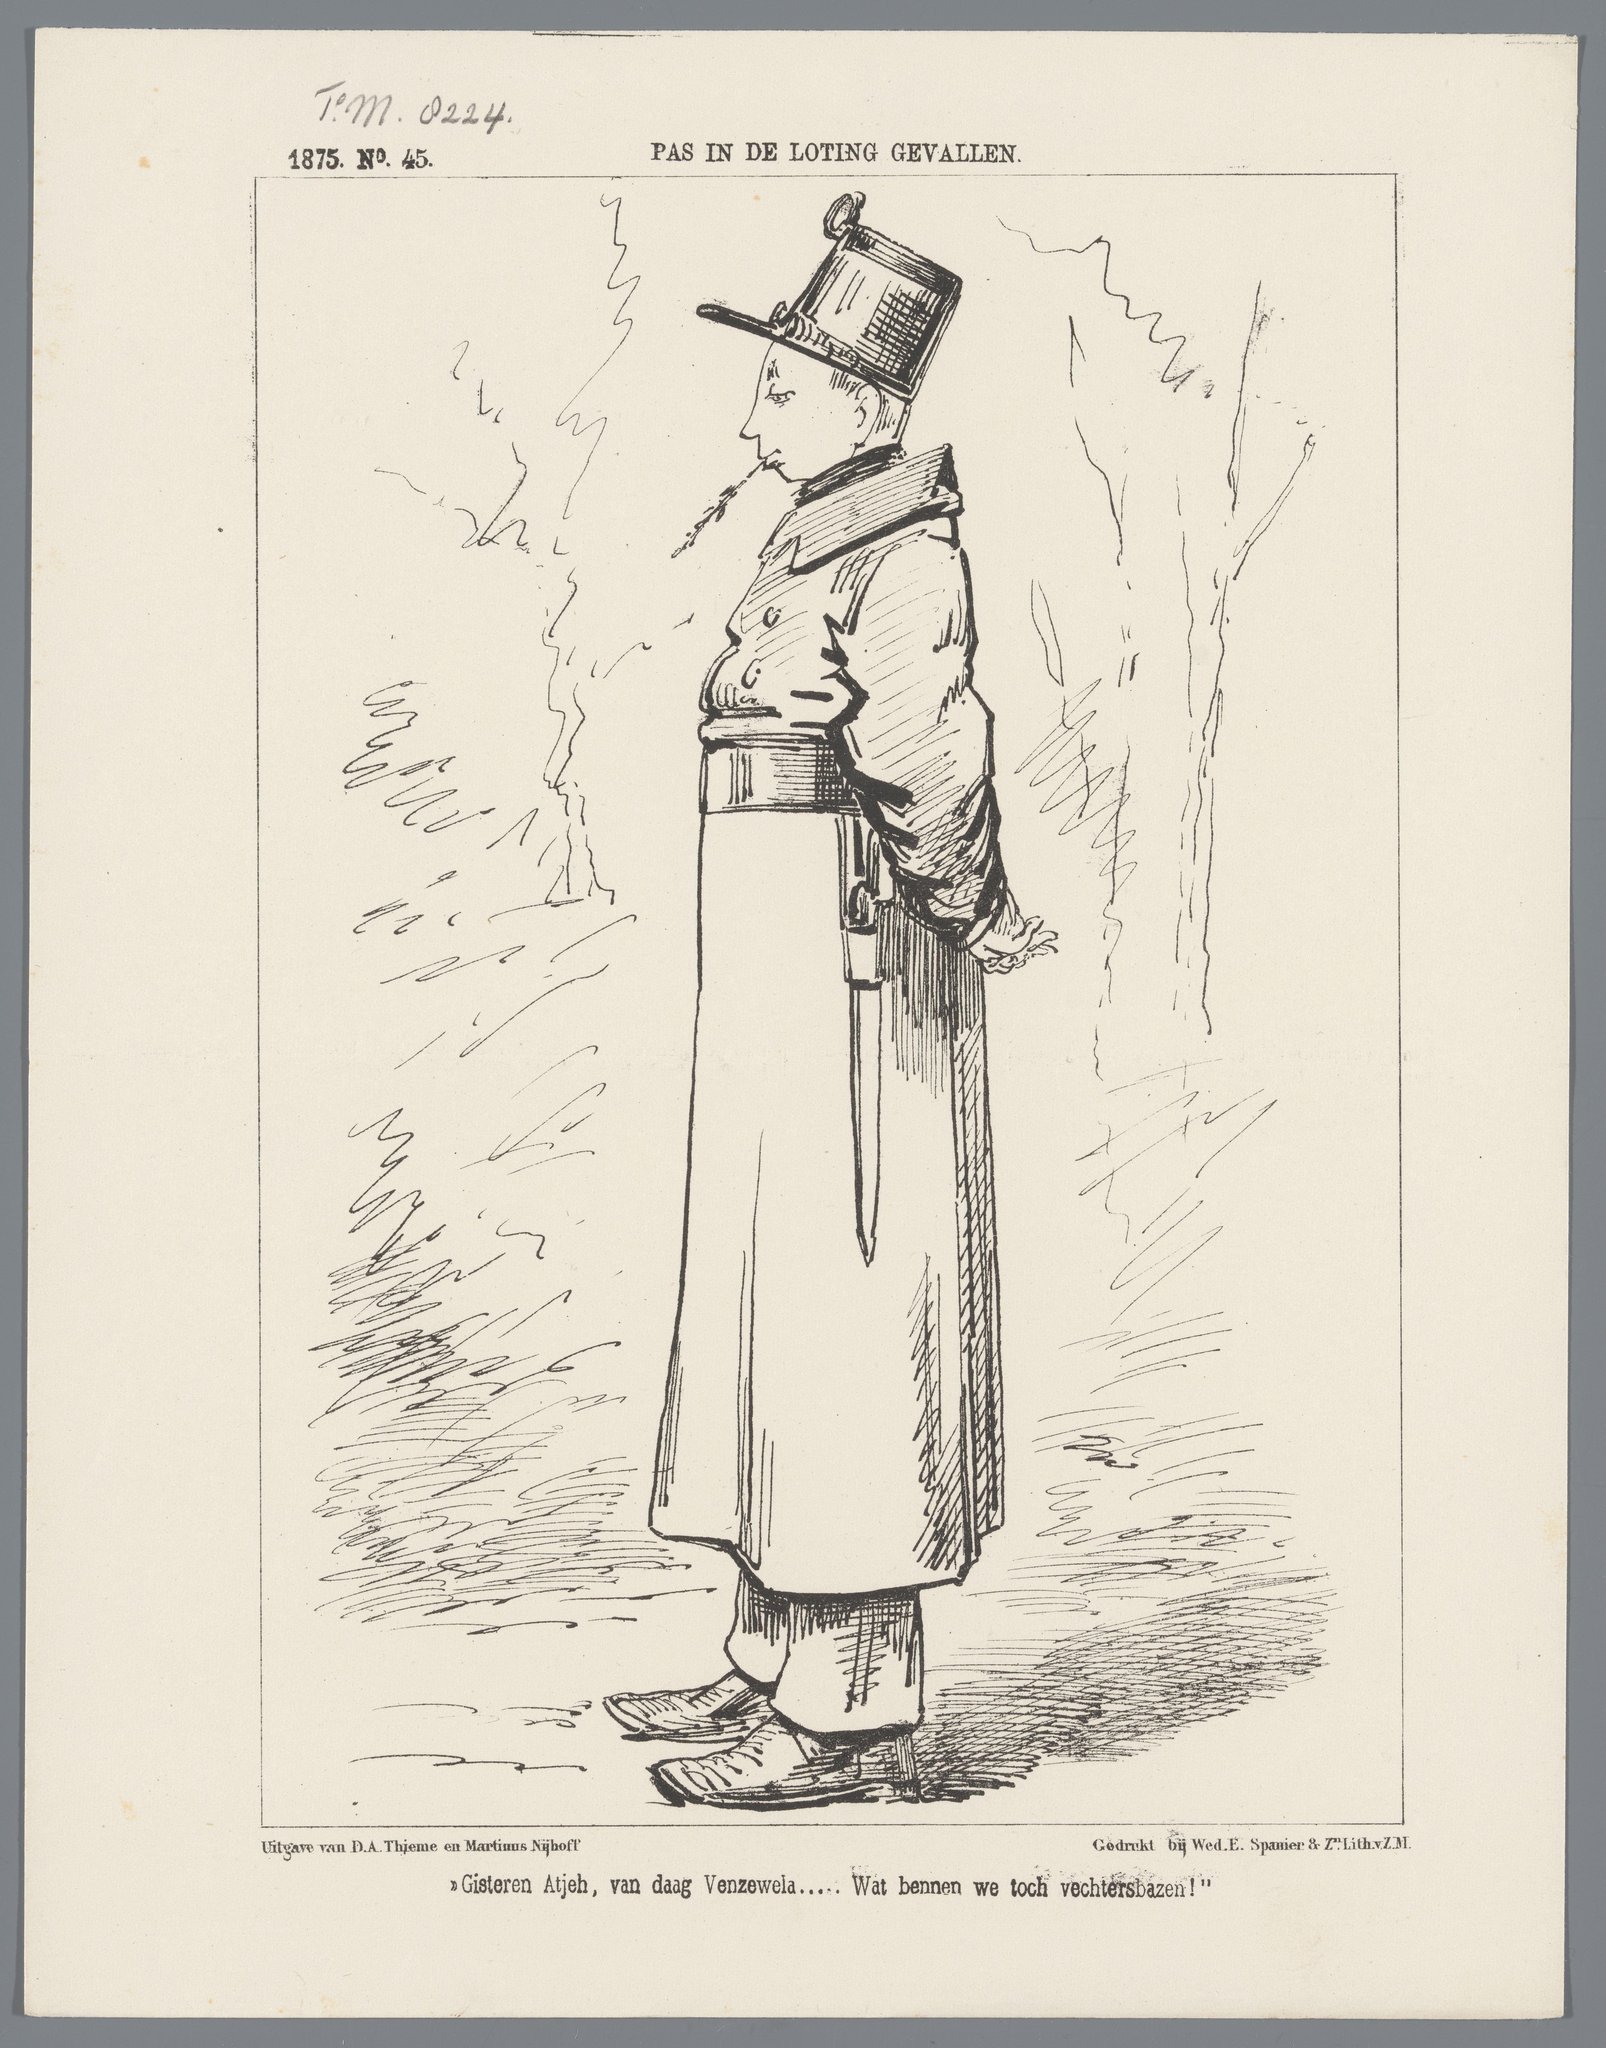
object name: print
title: Pas in de loting gevallen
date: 1875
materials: paper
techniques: lithograph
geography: arnhem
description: Spotprent op slechte staat van de Nederlandse krijgsmacht, 1875. Plaat verschenen bij het weekblad De Nederlandsche Spectator, nr. 45, 1875.